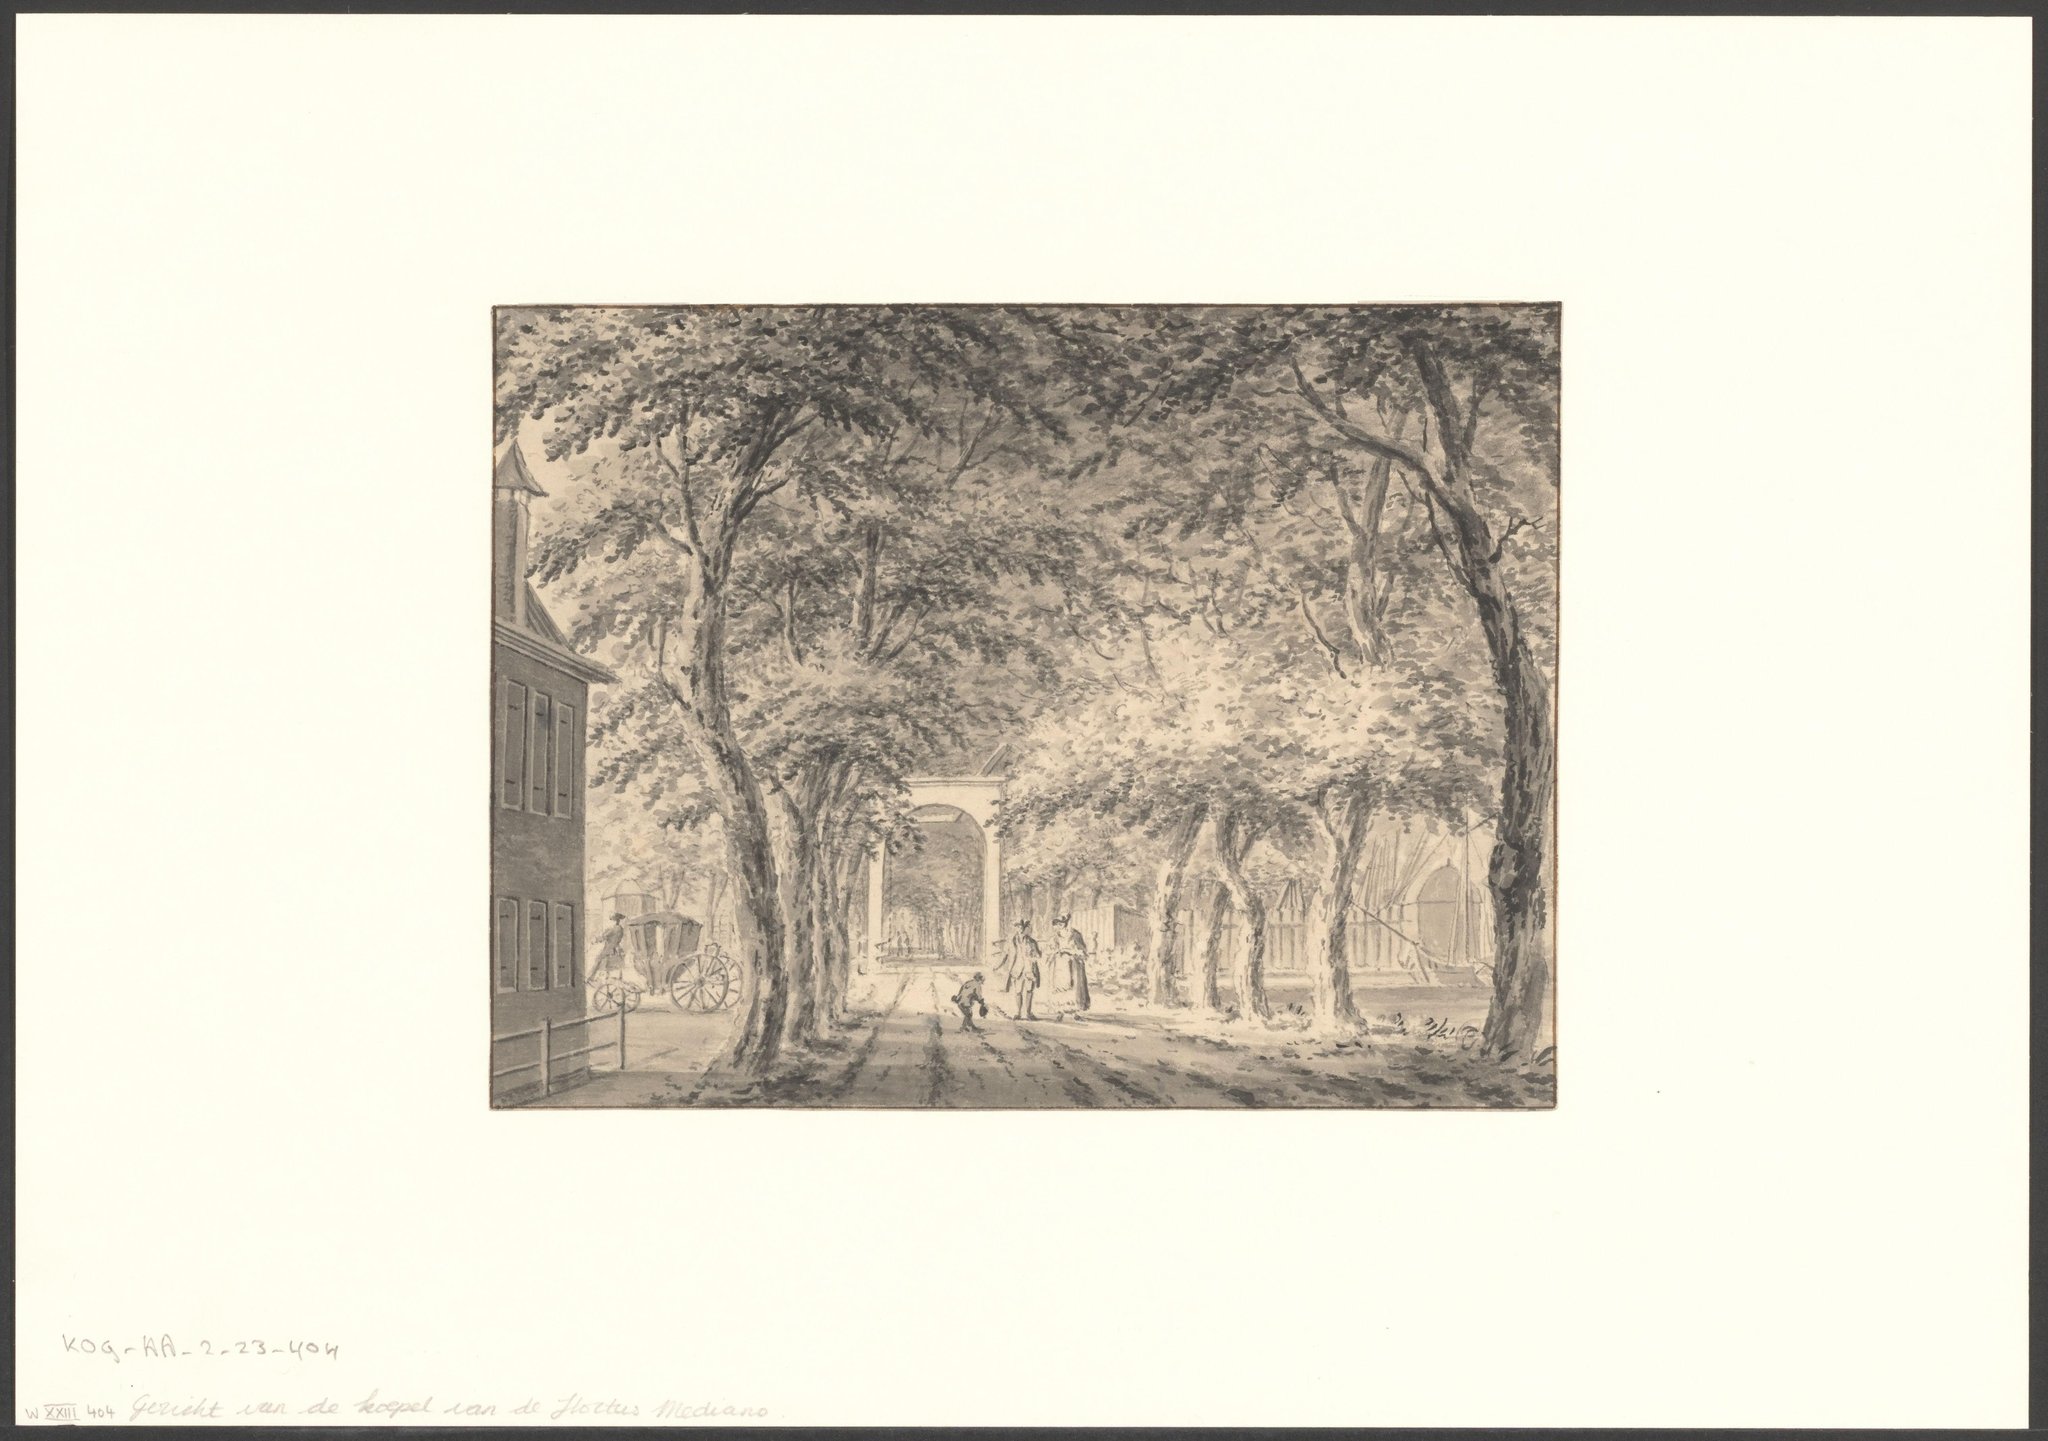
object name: drawing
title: Gezicht op de Plantage Doklaan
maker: Anonymous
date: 1700-1799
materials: ink, paper, pencil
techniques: brush, pen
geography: amsterdam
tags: city-view in general; 'veduta', bridge in city across river, canal, etc., public gardens, park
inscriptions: collector's mark: Lugt 800a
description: Tekening binnen de Atlas Van Eck ingedeeld op wijknummer 23.